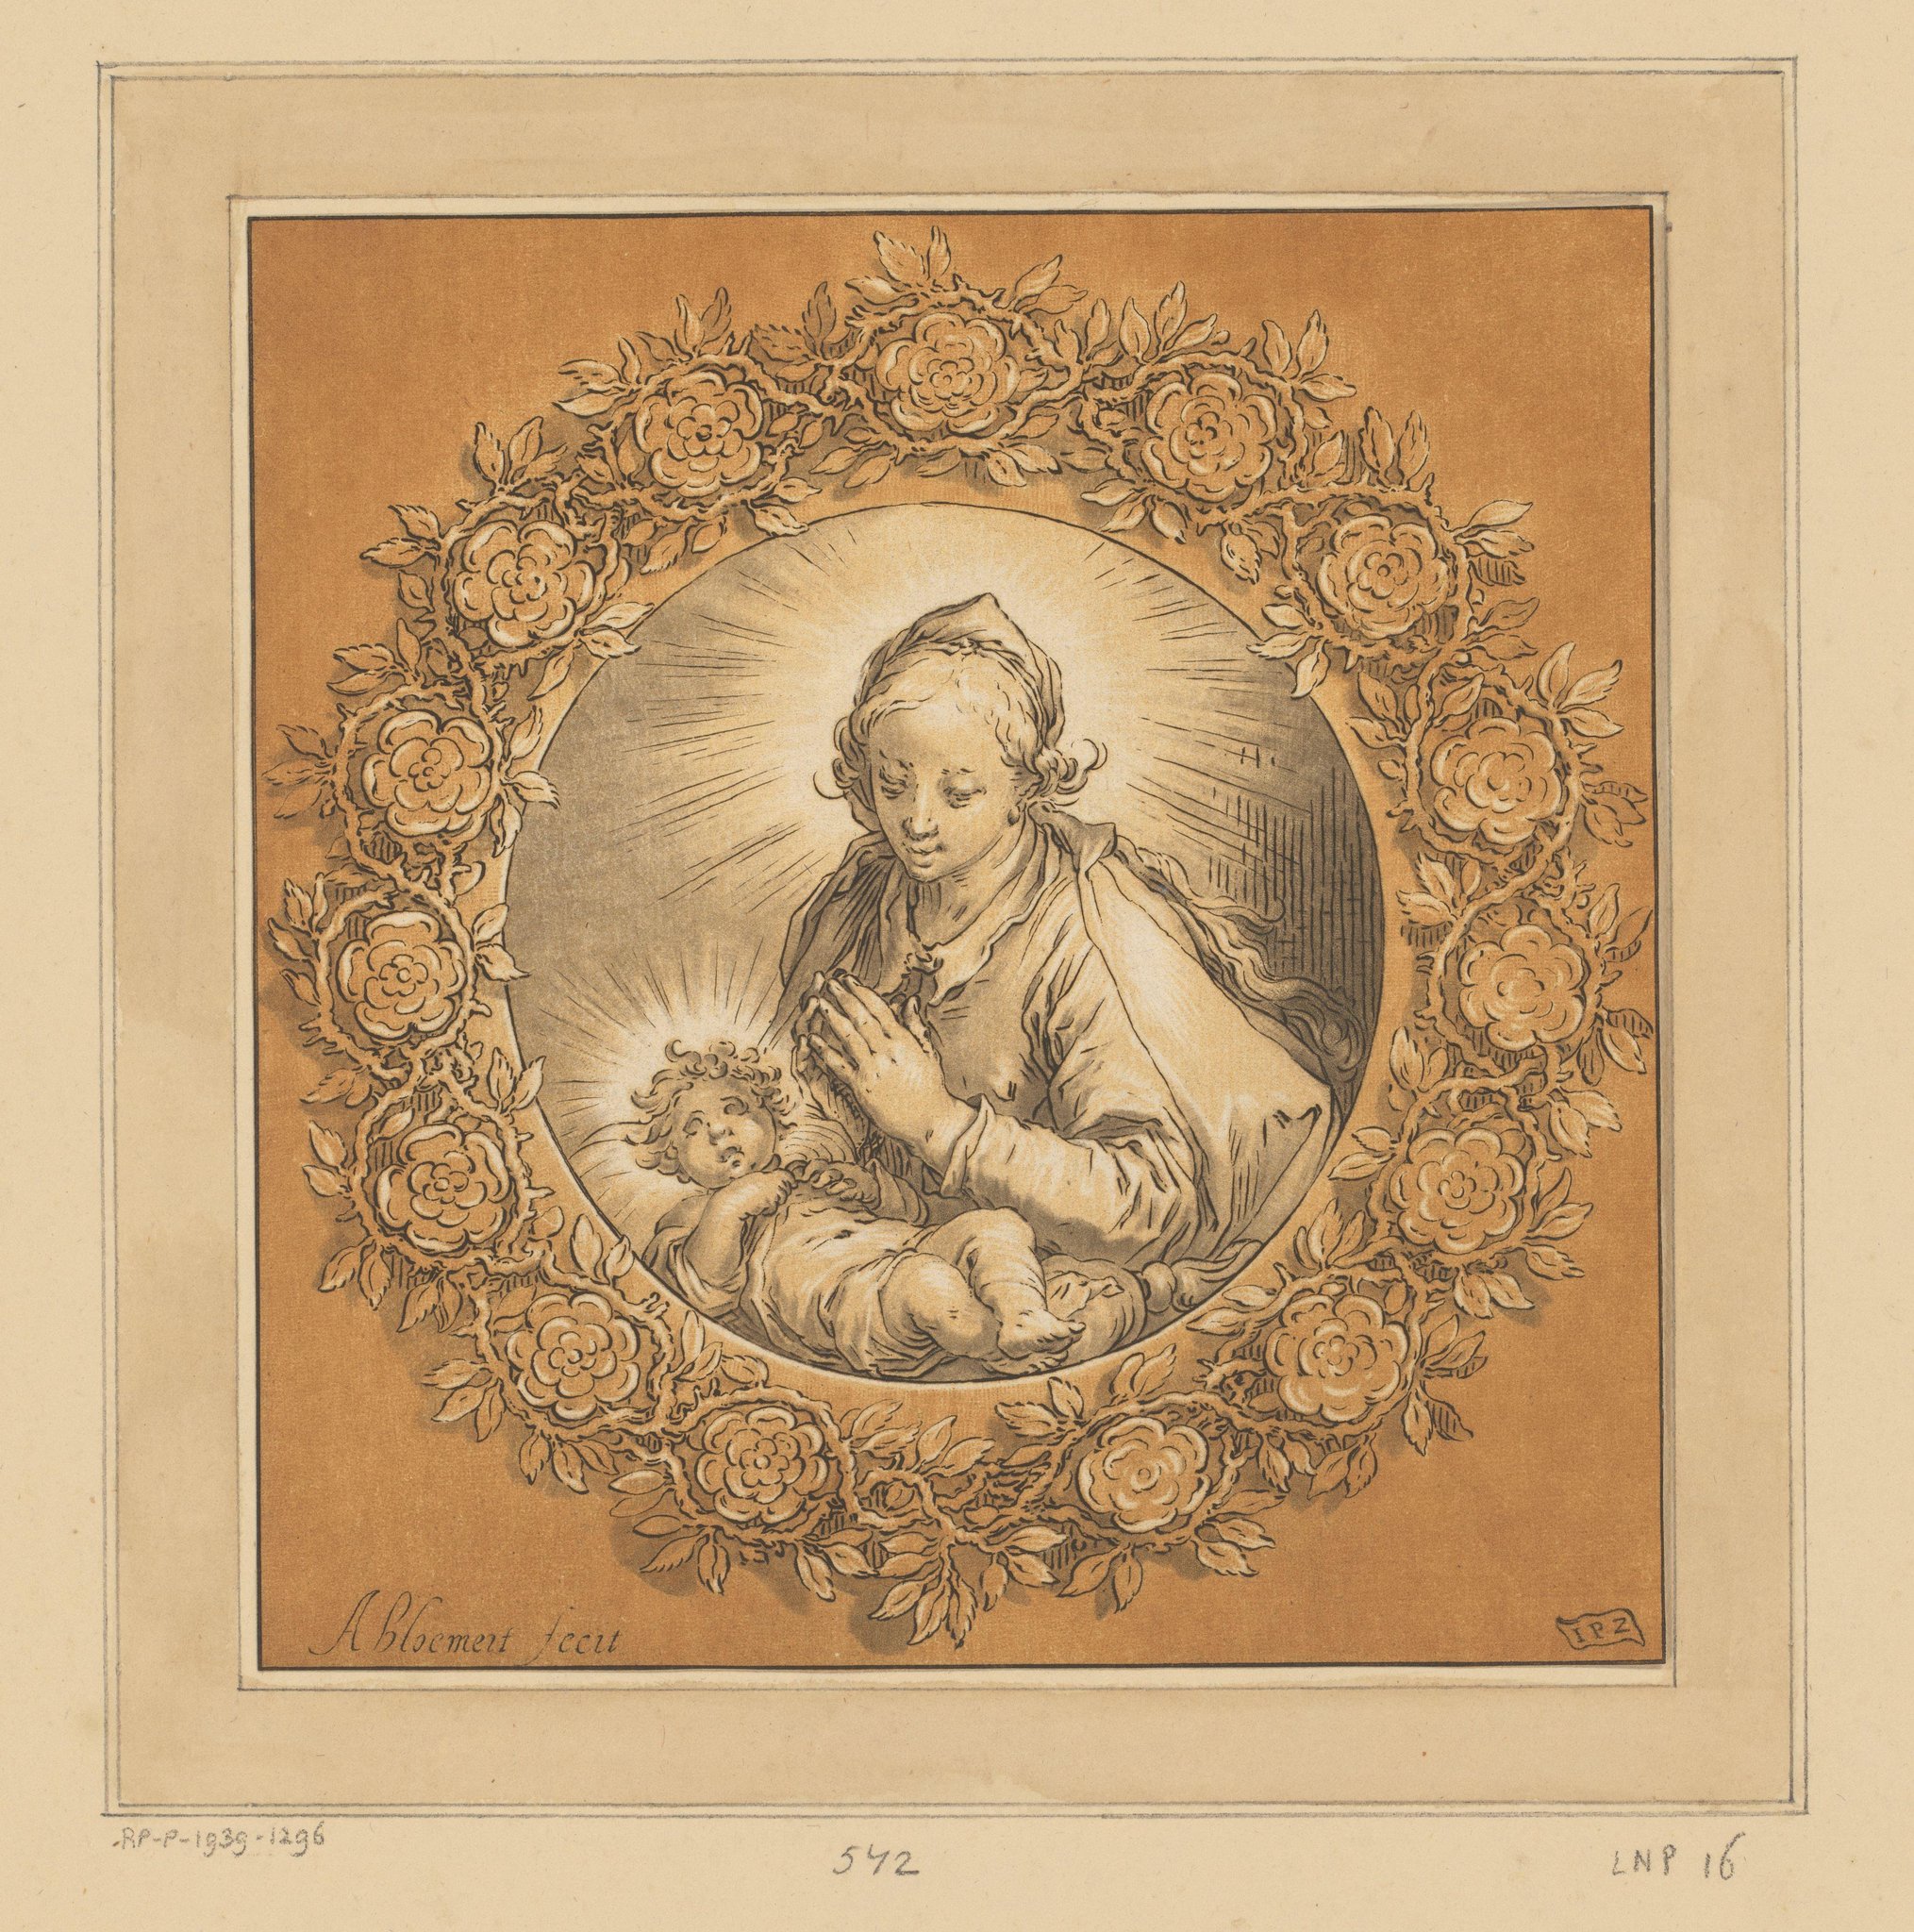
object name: print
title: Maria met Christuskind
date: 1769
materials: paper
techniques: roulette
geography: amsterdam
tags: madonna: i.e. mary with the christ-child, flowers: rose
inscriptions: inscription: ‘Abm Bloemaert del. Ploos van Amstel. J.C. Fecit. 1769.’, collector's mark: Lugt 2725, collector's mark: ‘RIJKS / MUSM’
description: Maria met gevouwen handen bij het Christuskind in een ronde, met rozen versierde, omlijsting. De prent ligt los in een album, zie blad 16.